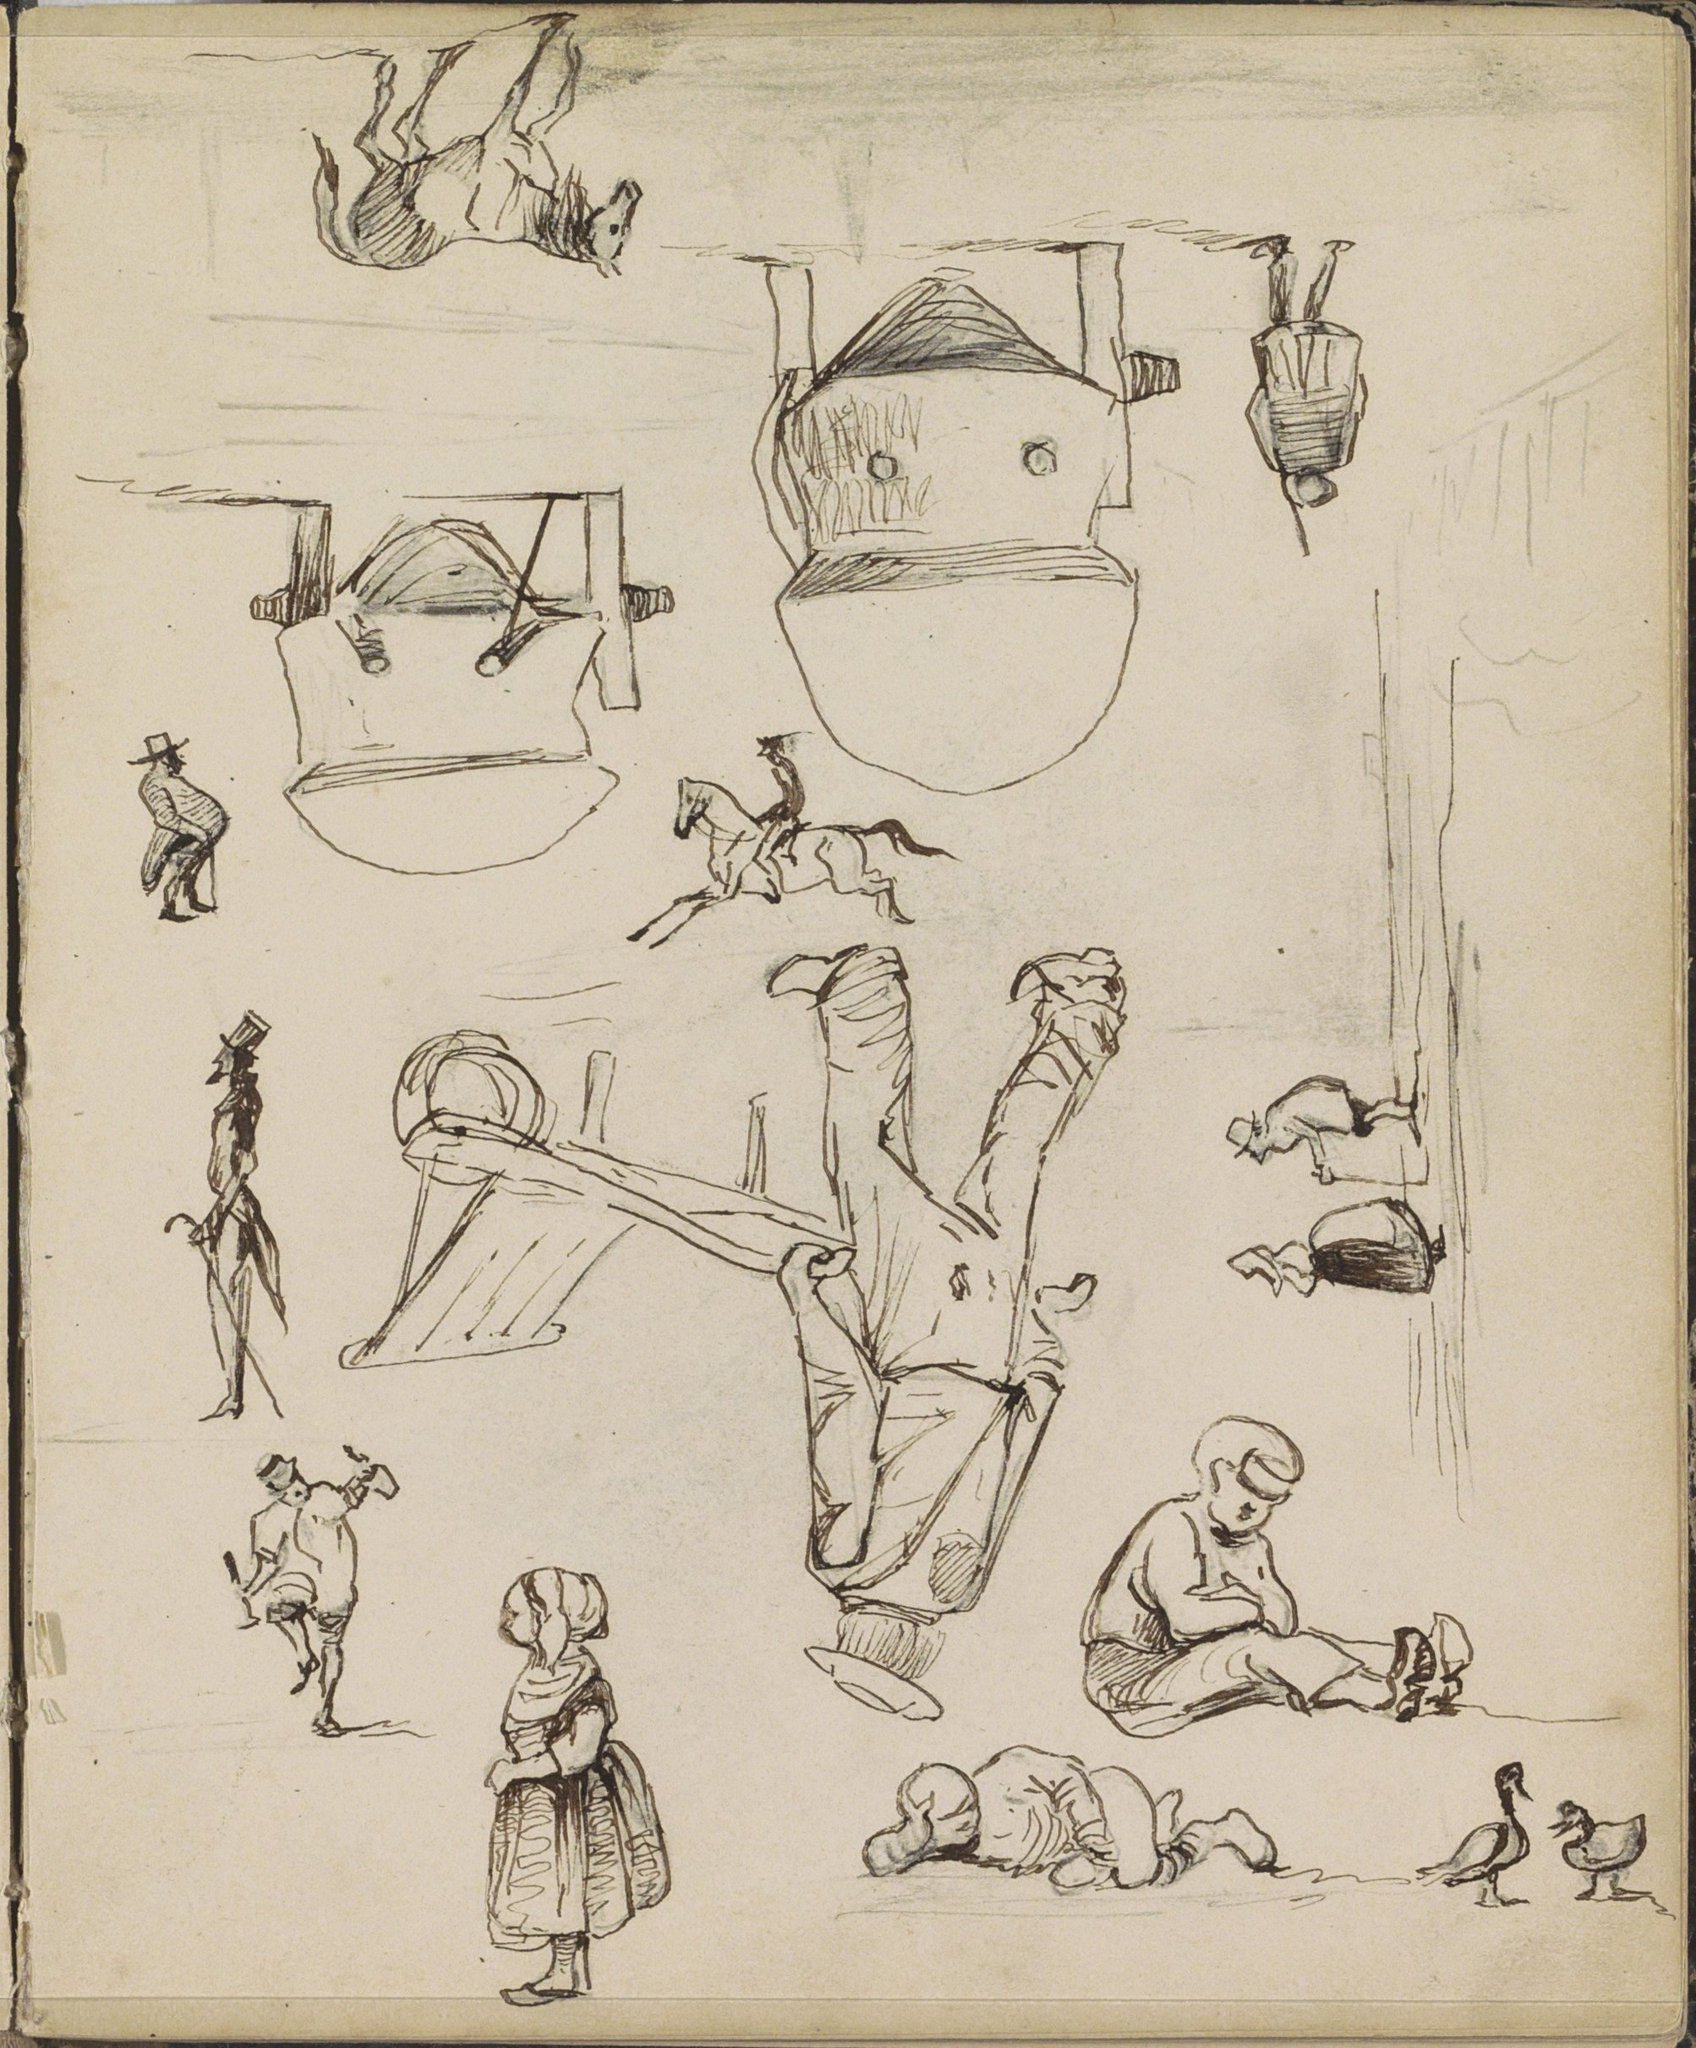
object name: sketchbook leaf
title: Studieblad, onder andere met een paard, ruiter en boeren en boerinnen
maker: johannes tavenraat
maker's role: draughtsman, painter, print maker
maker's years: 1809-1881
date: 1841-1853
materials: ink, paper, pencil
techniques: pen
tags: riding a horse, ass, or mule; rider, horseman, farmers, horse, water-birds: duck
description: Tevens enkele figuurstudies en eenden. Blad 11 recto uit een schetsboek met 87 bladen.